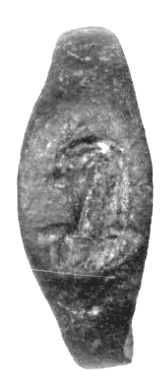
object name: ring, finger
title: Finger Ring with a head of Horus on the bezel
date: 1-200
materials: copper alloy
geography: egypt